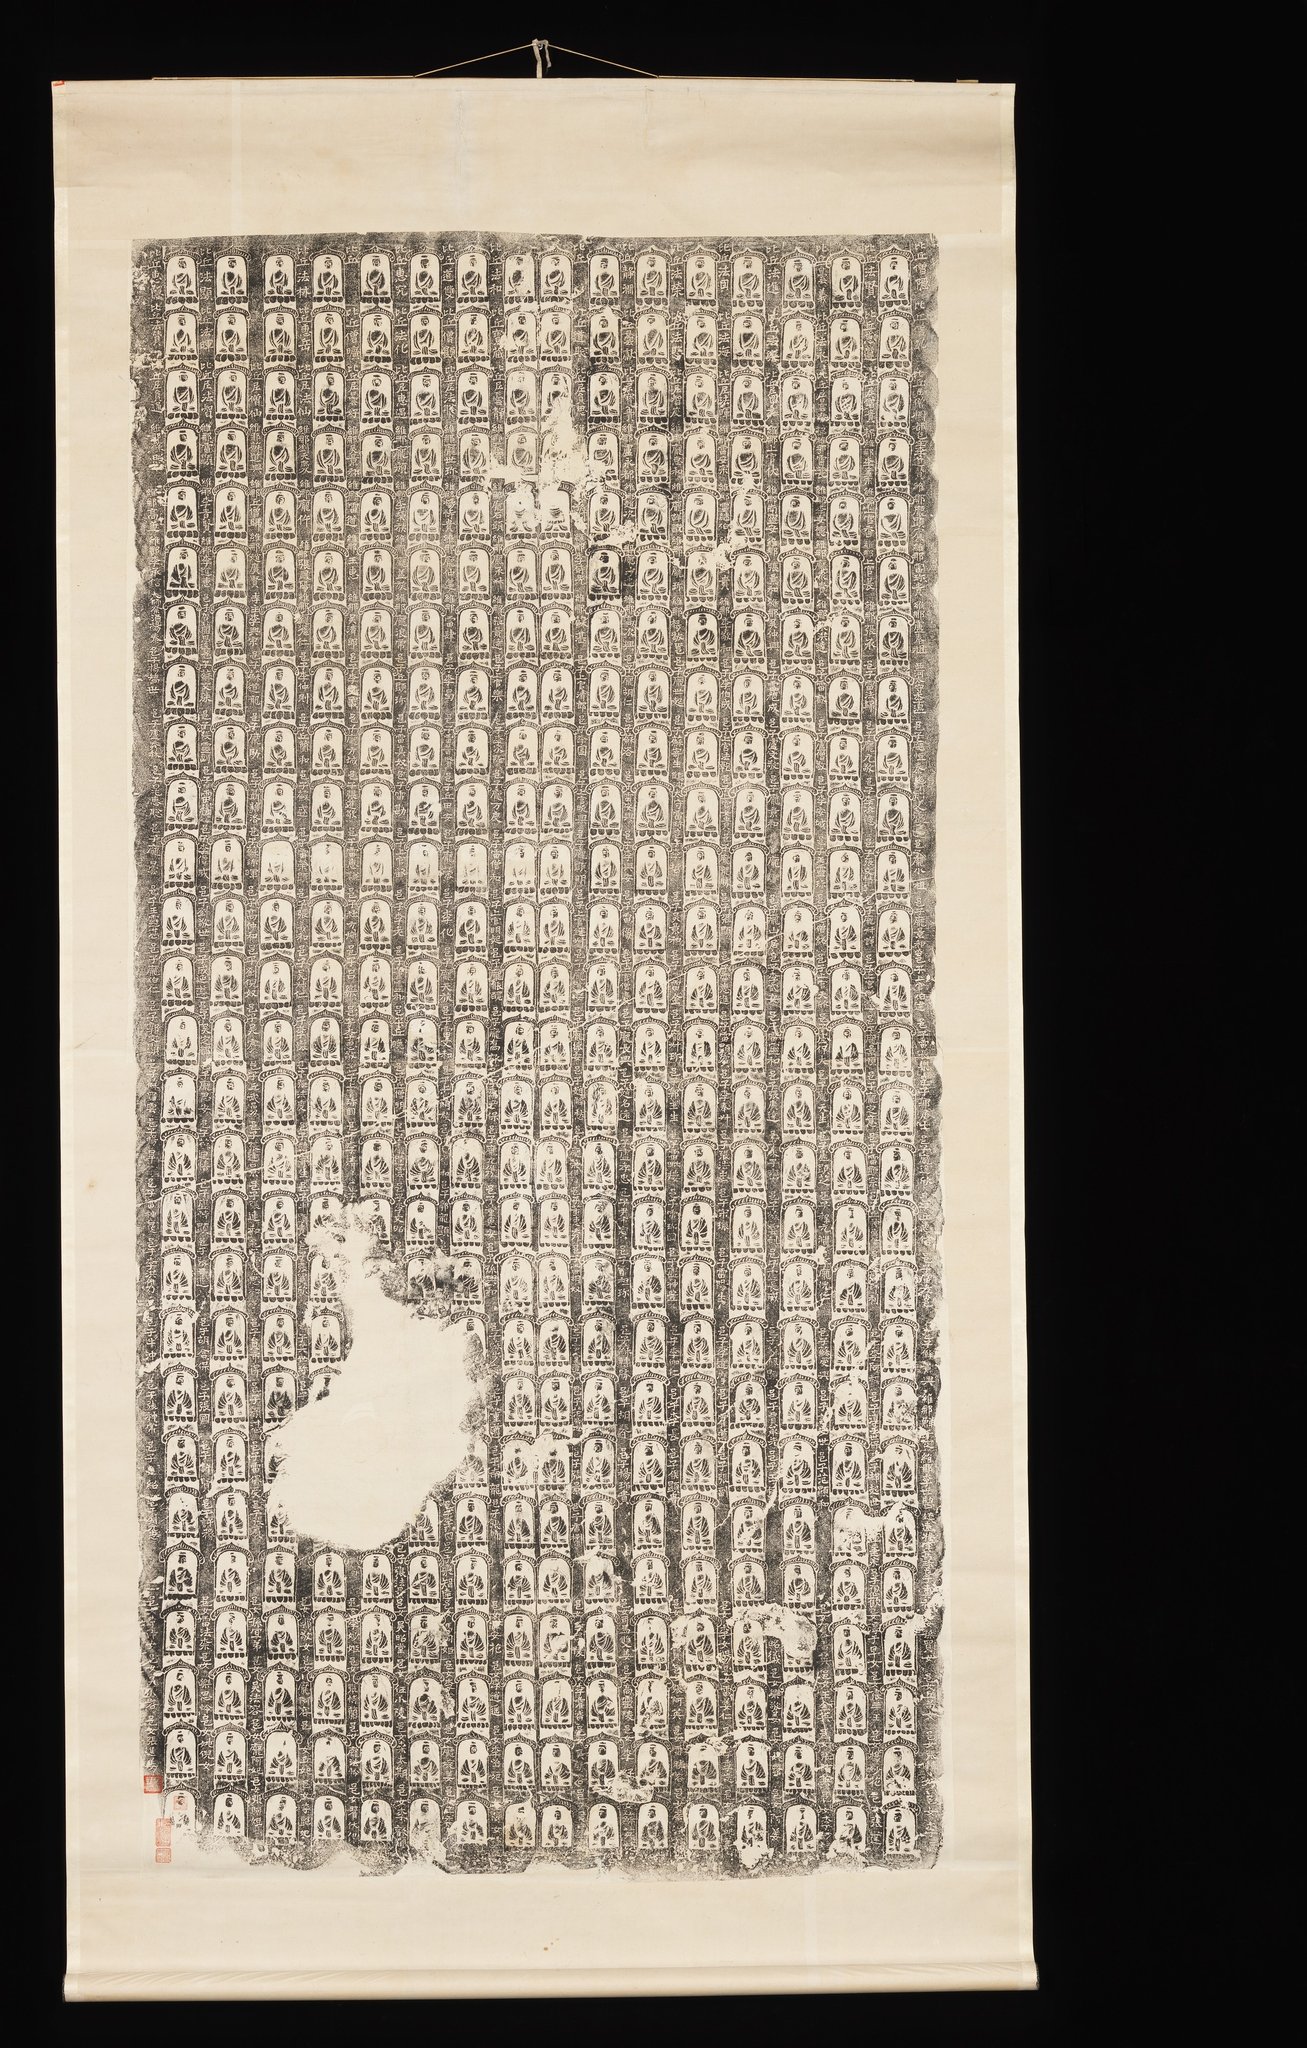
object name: rubbing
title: Rubbing of the Back of theTrübner Stele (29.72)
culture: chinese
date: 1800-1935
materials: ink, paper